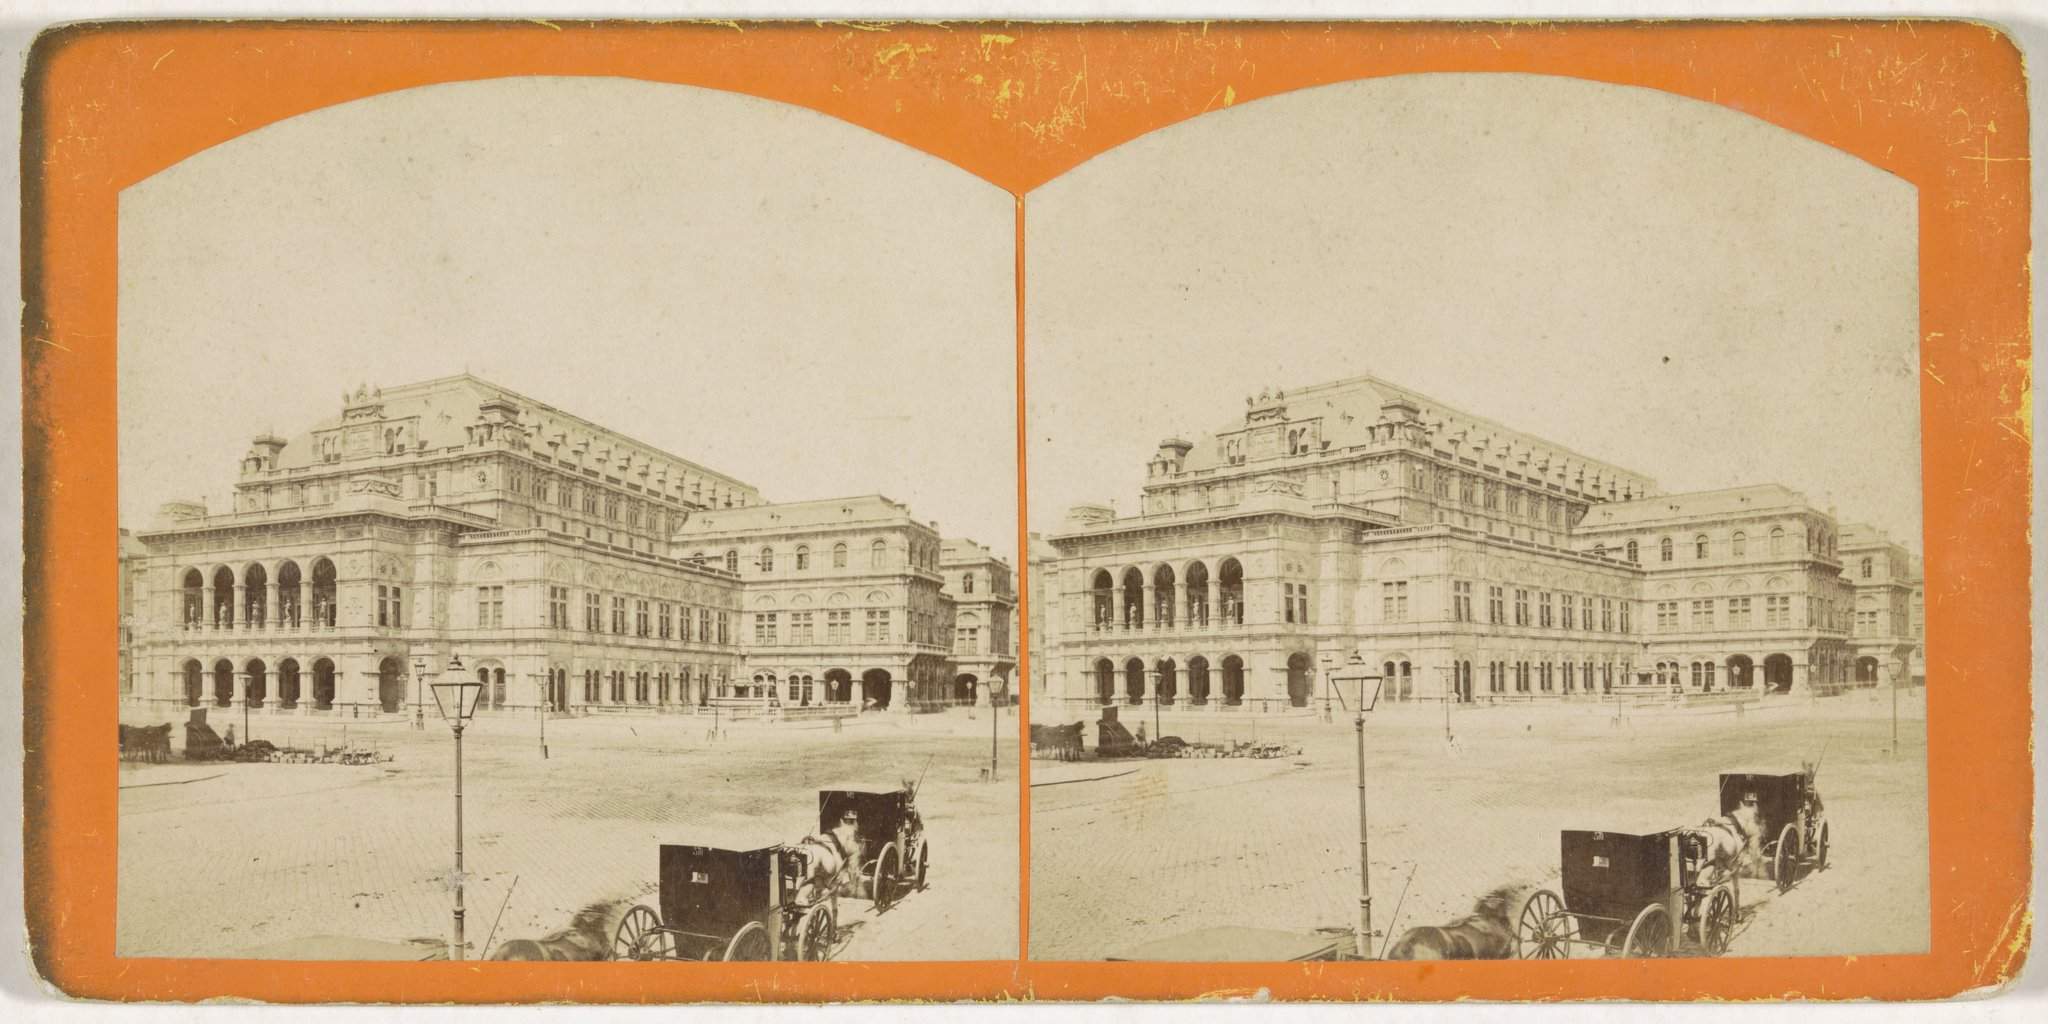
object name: stereograph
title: Wien, neues Opernhaus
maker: Anonymous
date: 1868-1880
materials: cardboard, paper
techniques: albumen print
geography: vienna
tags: opera house